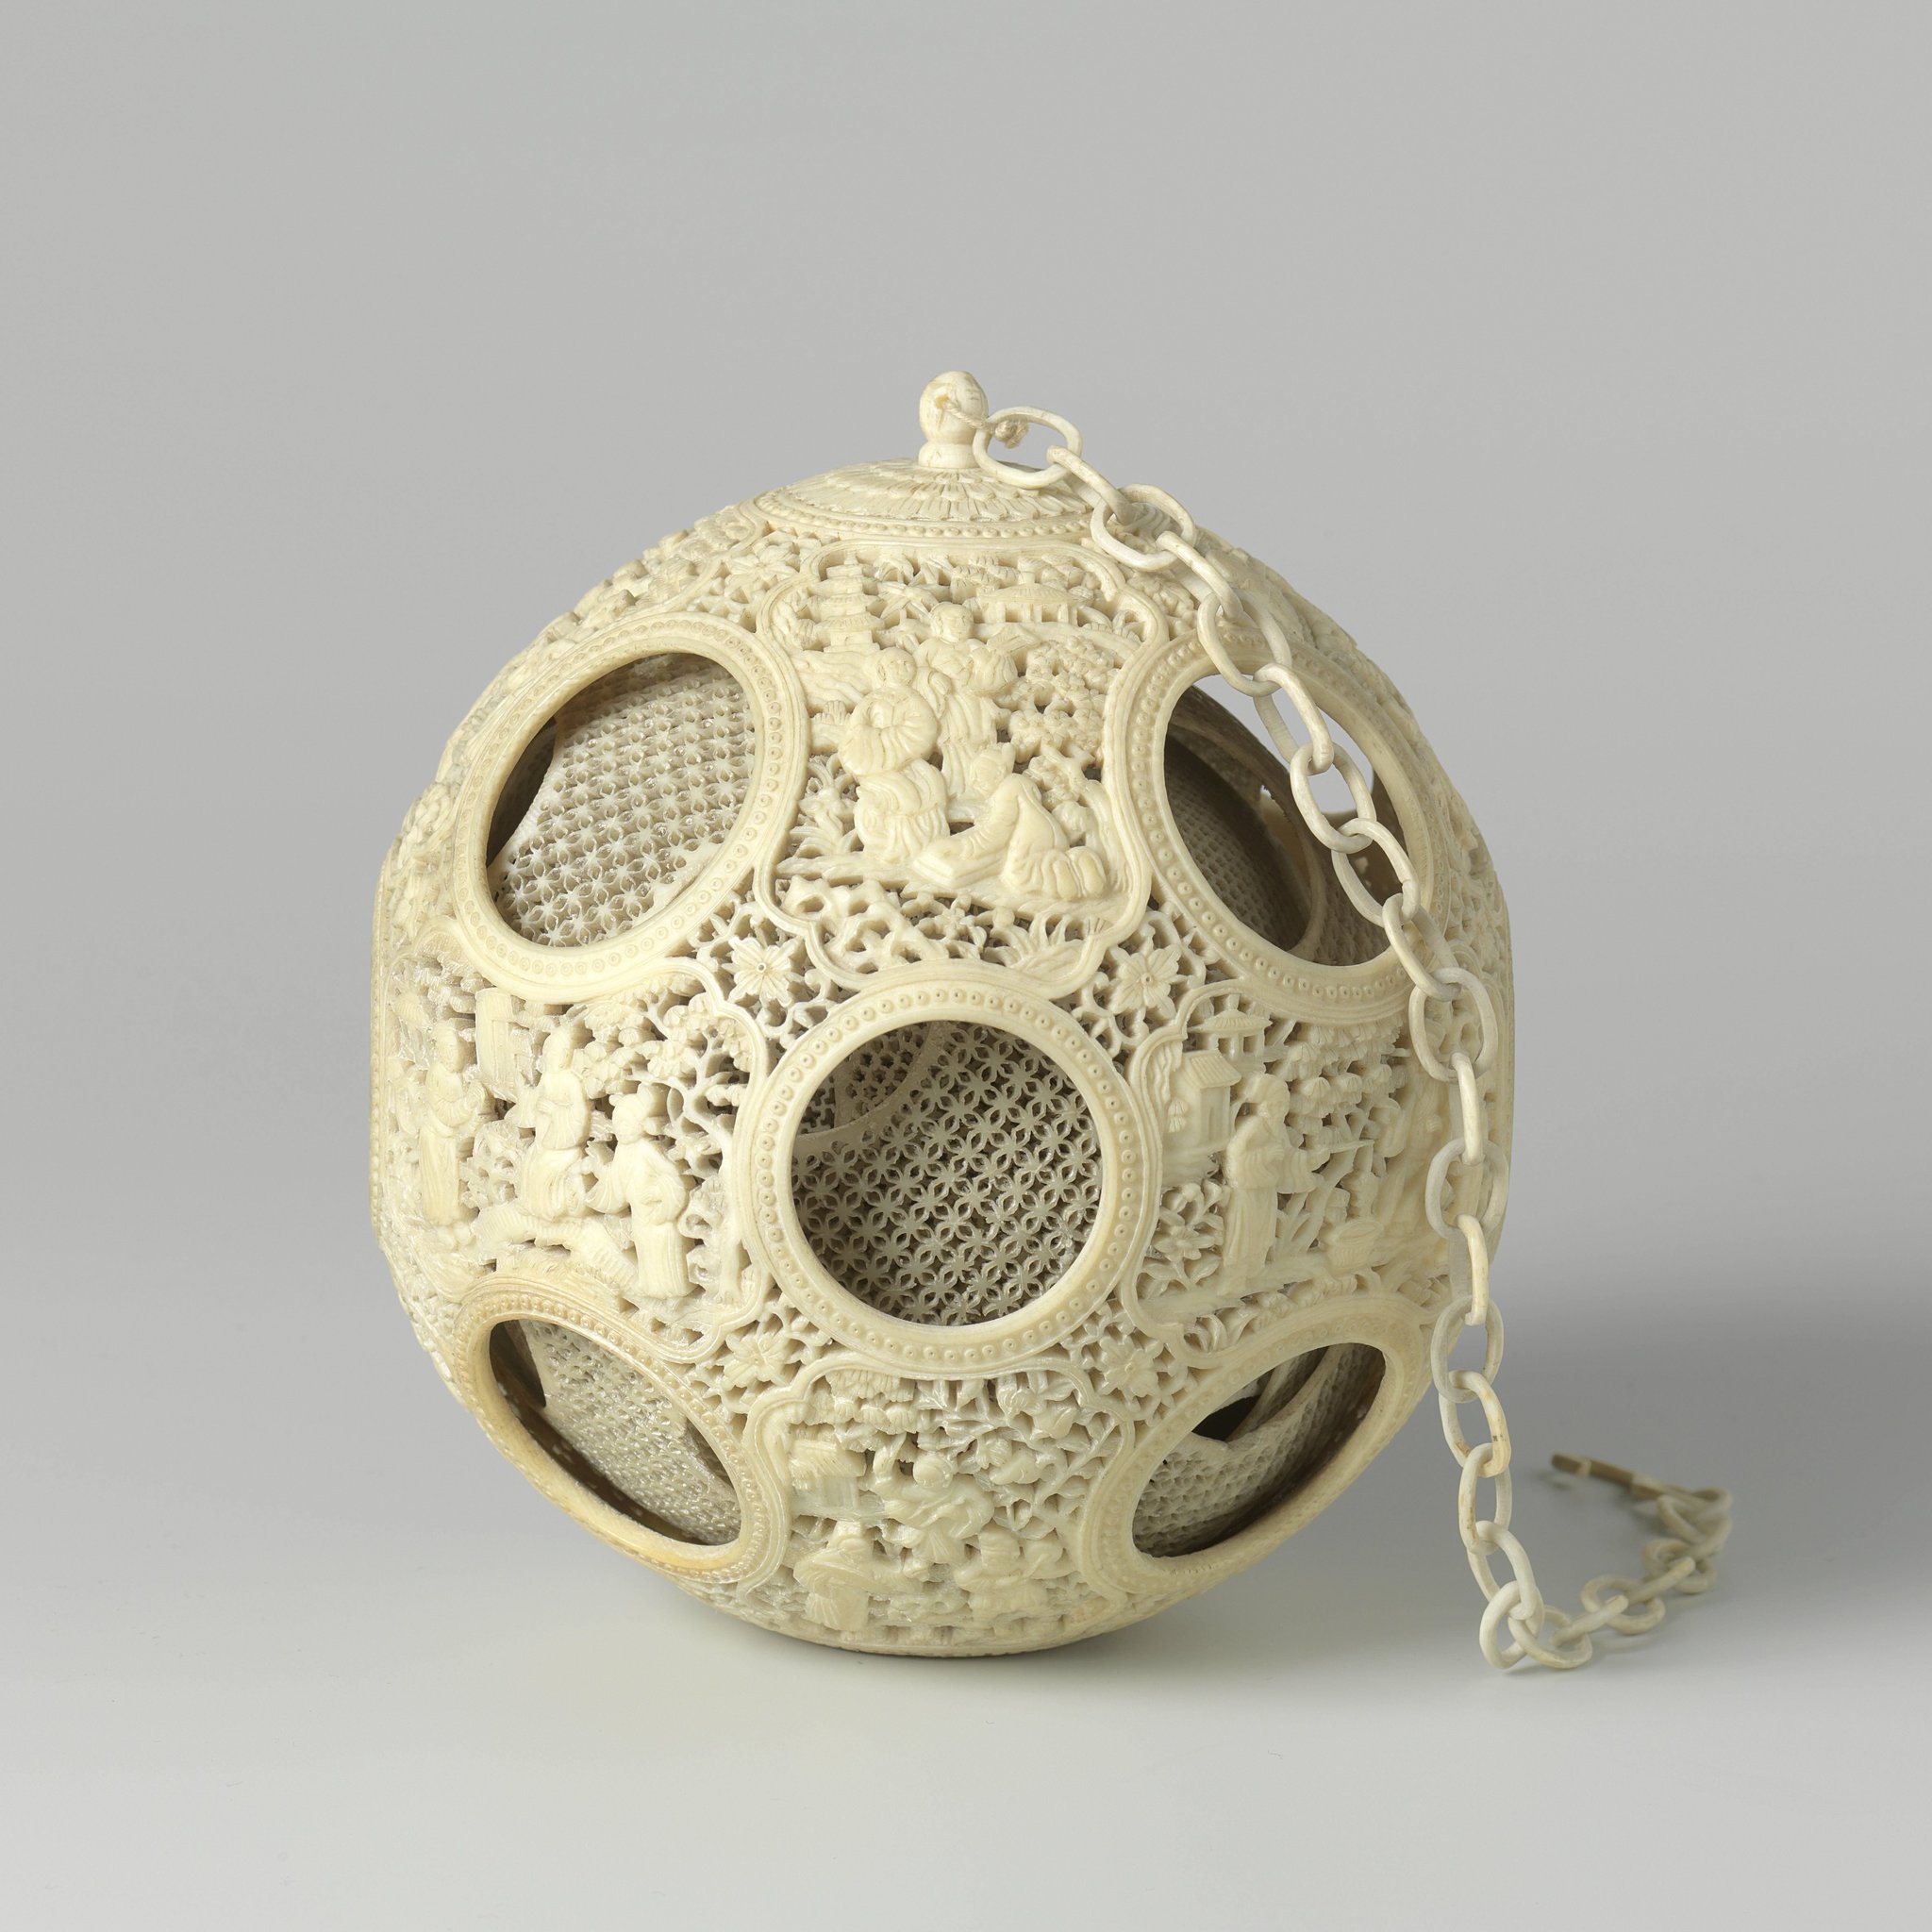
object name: sierstuk, sierobject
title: Ivoren bol met met verschillende opengewerkte concentrische bollen en kwast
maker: Anonymous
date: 1800-1825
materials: ivory, textile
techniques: cutting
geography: guangdong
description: Ivoren bol met dertien ronde gaten. De wand is in reliëf gesneden en deels opengewerkt. Tuusen de gaten bevinden zich velden met figuren in een landschap, buiten deze velden bloemranken. Door de gaten zijn de 'binnenschillen' zichtbaar, opengewerkt in verschillende geometrische patronen. Aan de bovenzijde een ketting en aan de onderzijde een (verkleurde) oranje kwast.